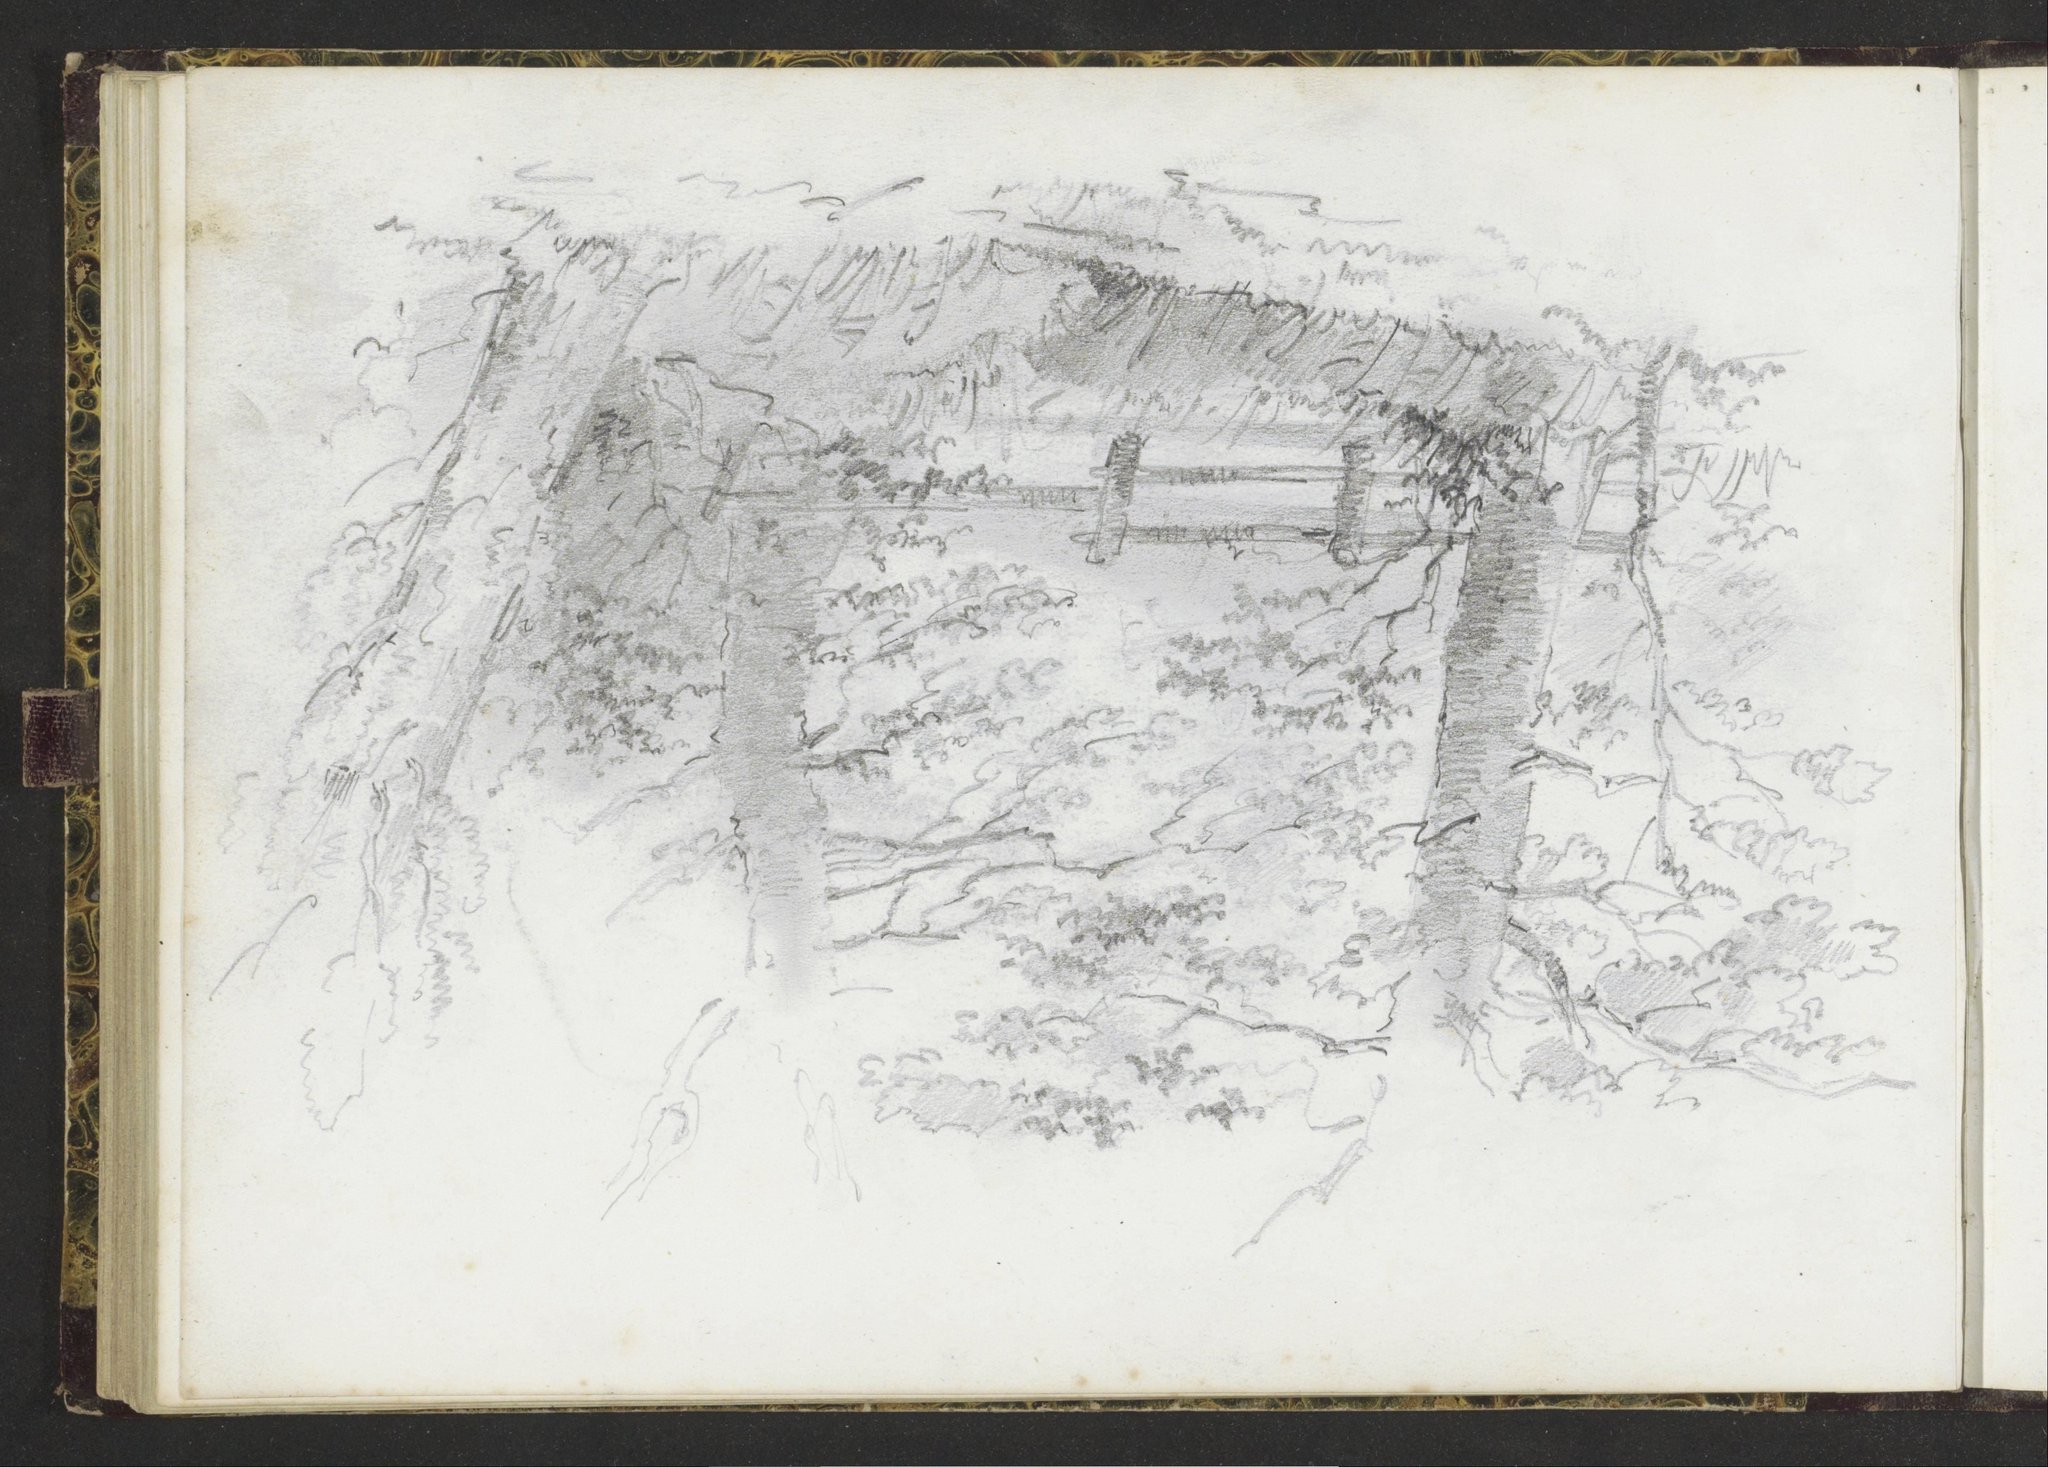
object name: sketchbook leaf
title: Bomen bij een hek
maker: lambertus lingeman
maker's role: draughtsman, painter, print maker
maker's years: 1829-1894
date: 1839-1894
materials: paper, pencil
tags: trees, fence, wall, paling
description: Blad 44 verso uit een schetsboek met 51 bladen.